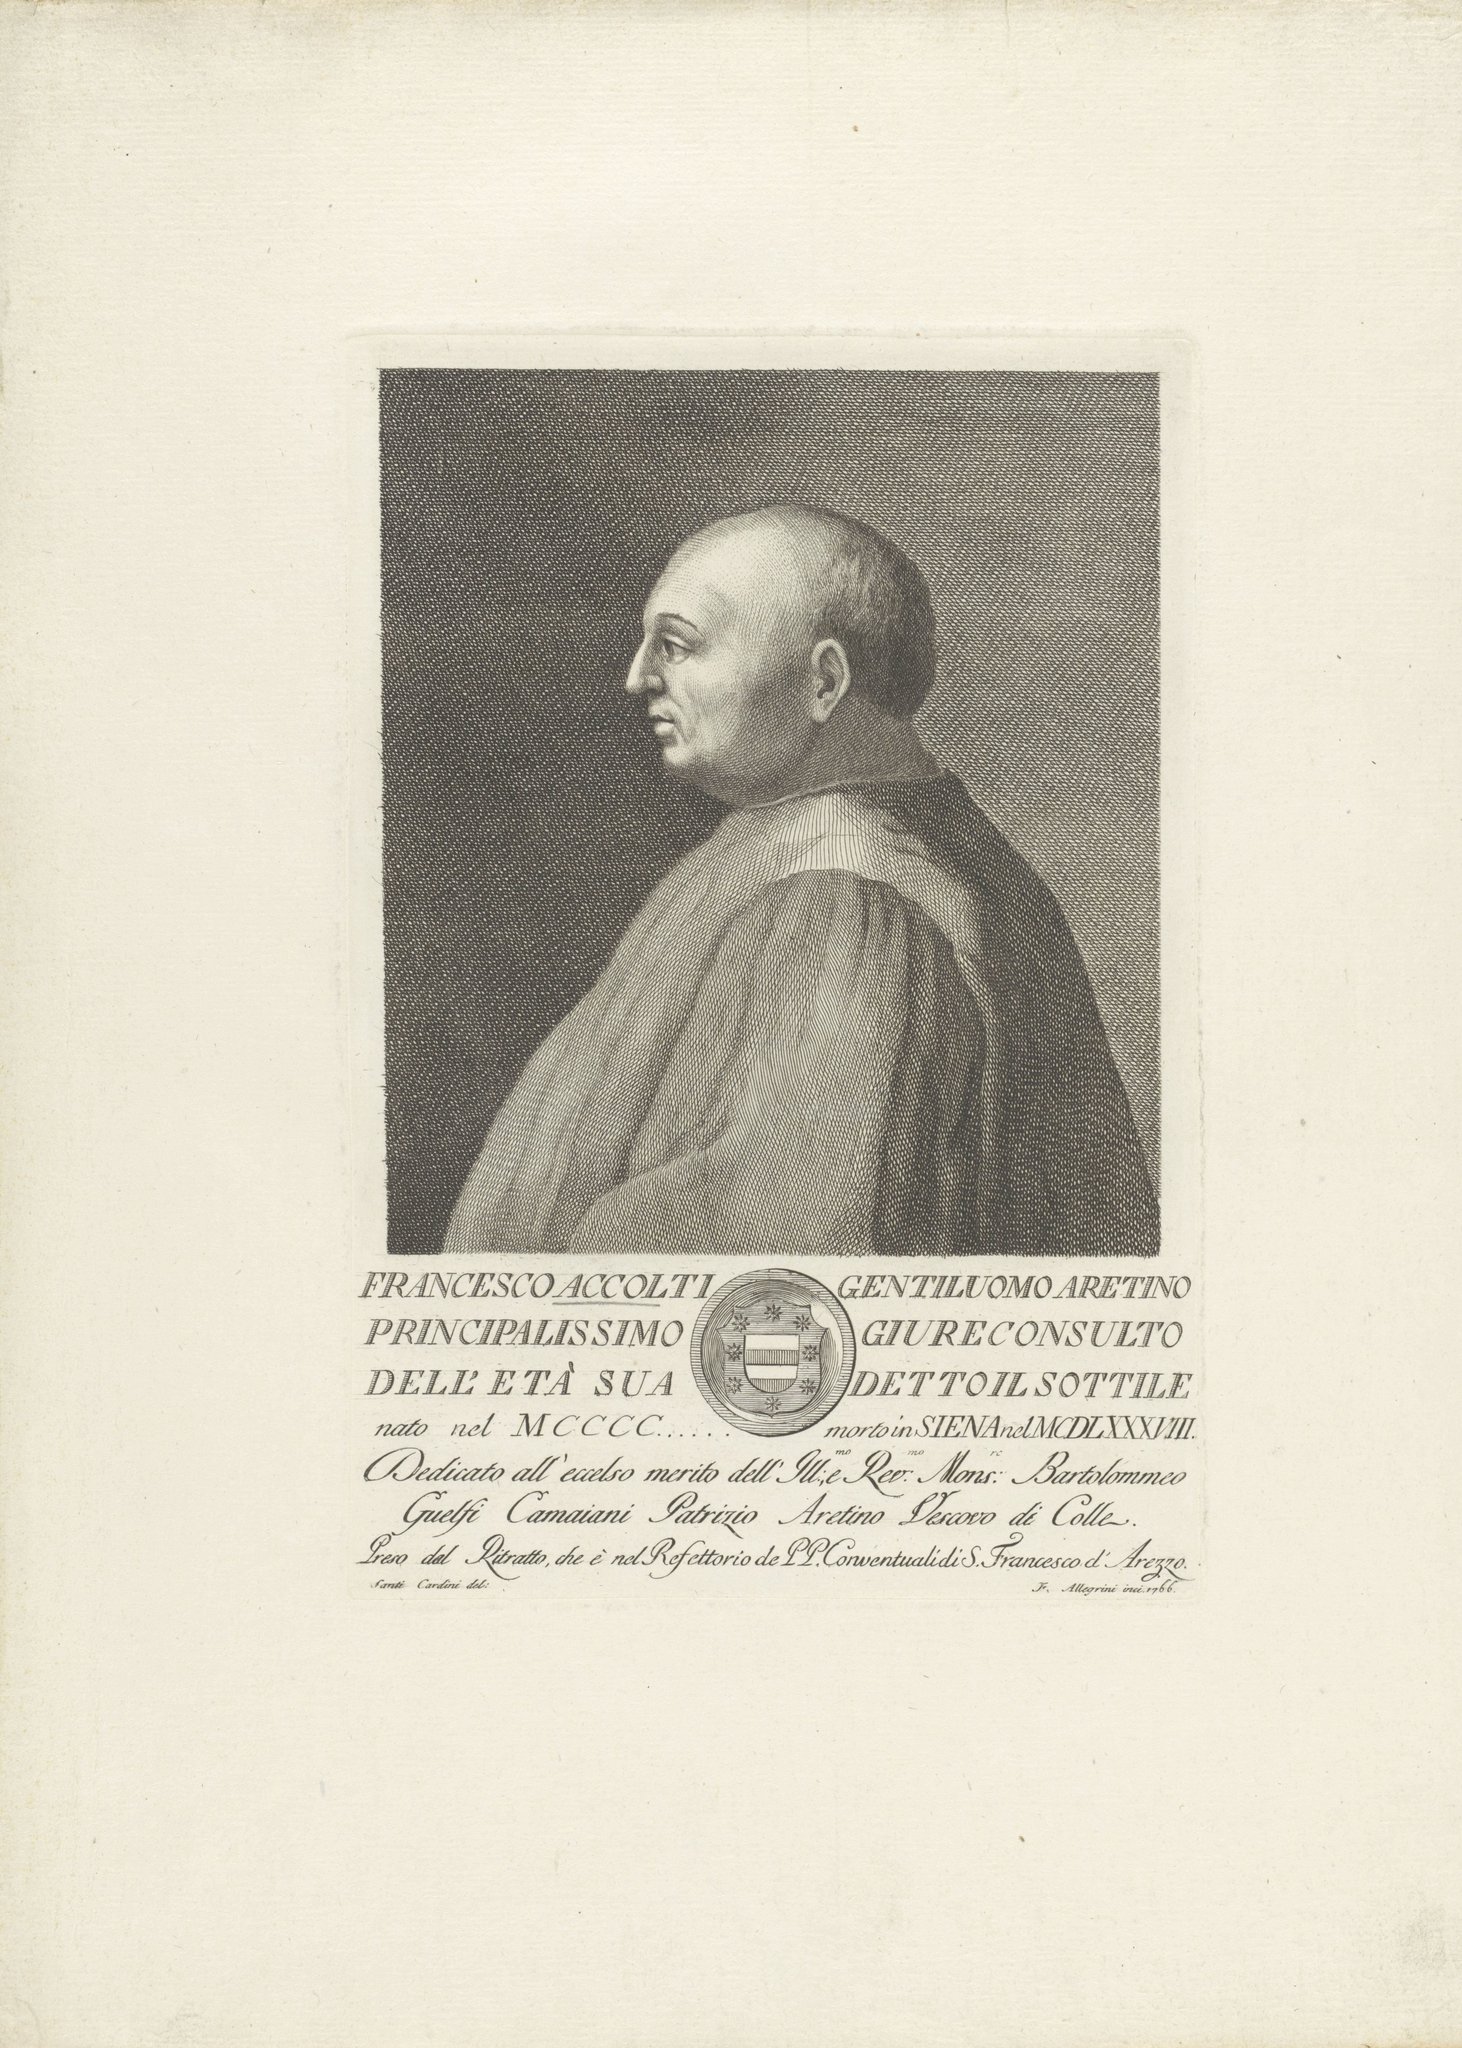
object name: print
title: Portret van Francesco Accolti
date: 1766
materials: paper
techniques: engraving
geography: italy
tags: historical persons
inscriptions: collector's mark: Lugt 2228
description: Deze prent maakt deel uit van een reeks portretprenten van onbekende omvang. De prenten zijn gemaakt door meedere prentmakers, onder wie Francesco Allegrini en Carlo en Raimondo Faucci.